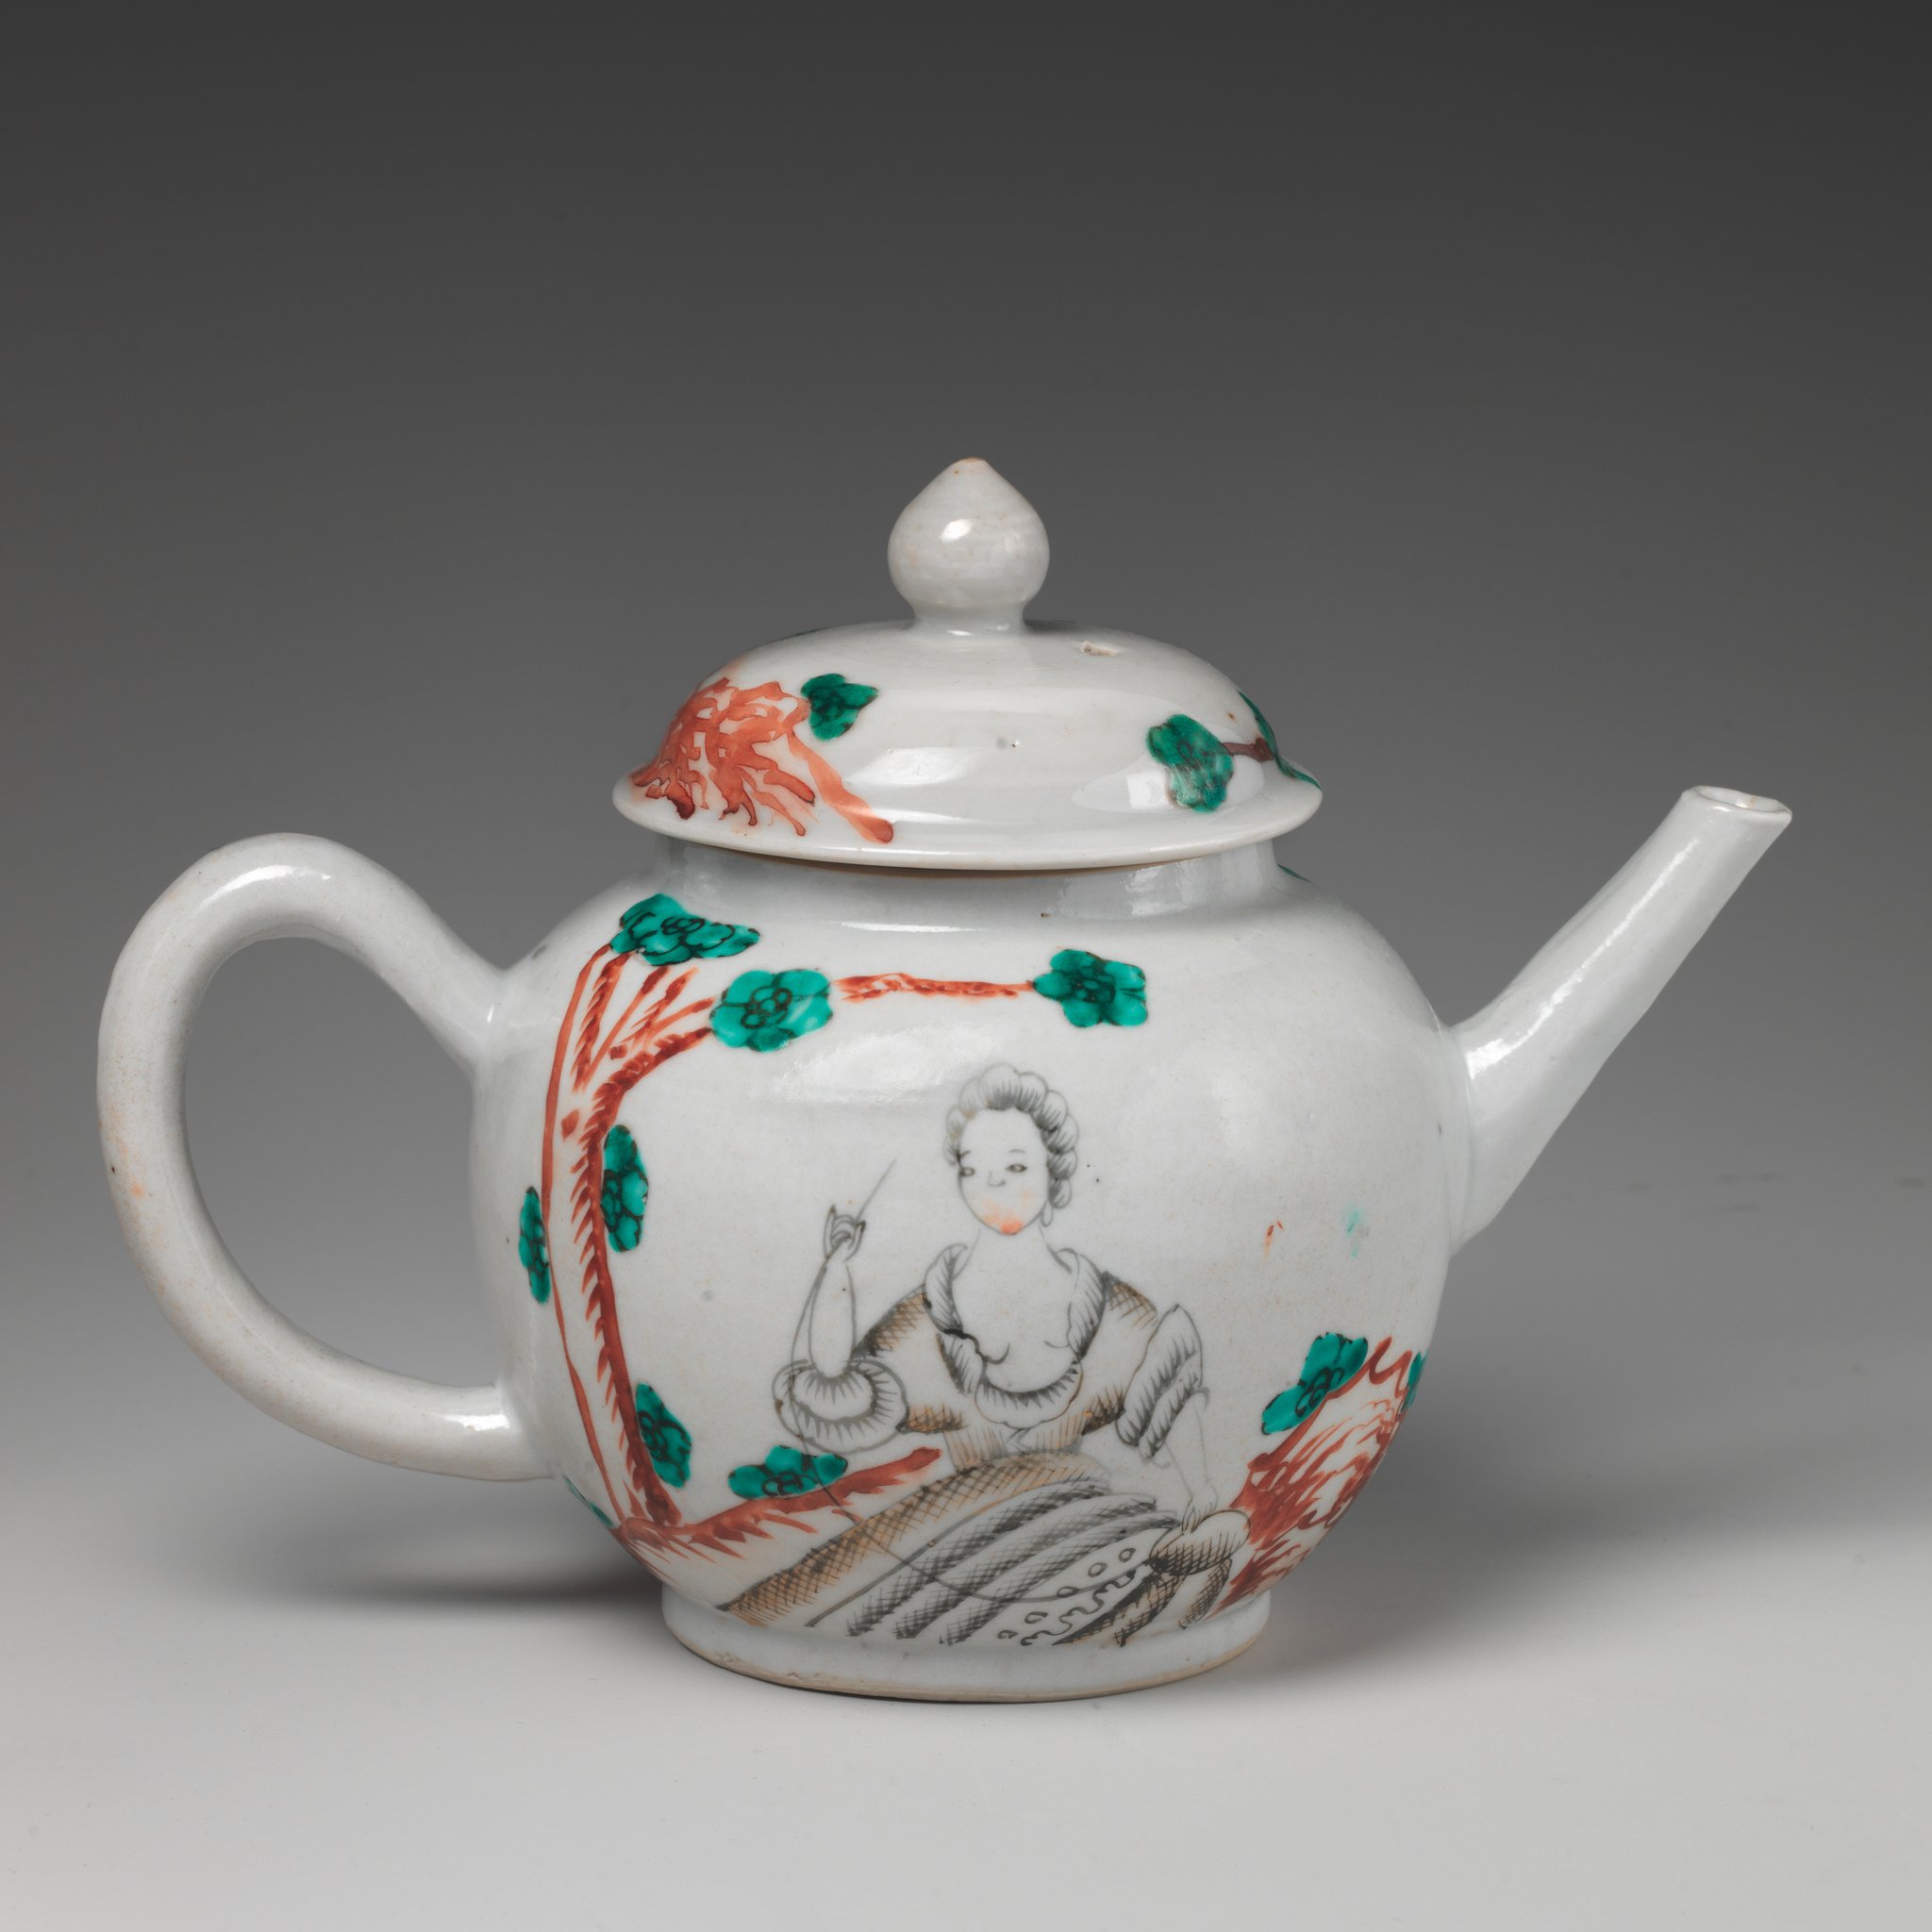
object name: teapot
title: Teapot with portrait of a woman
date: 1750-1770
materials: enamel, hard paste porcelain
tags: women,sewing